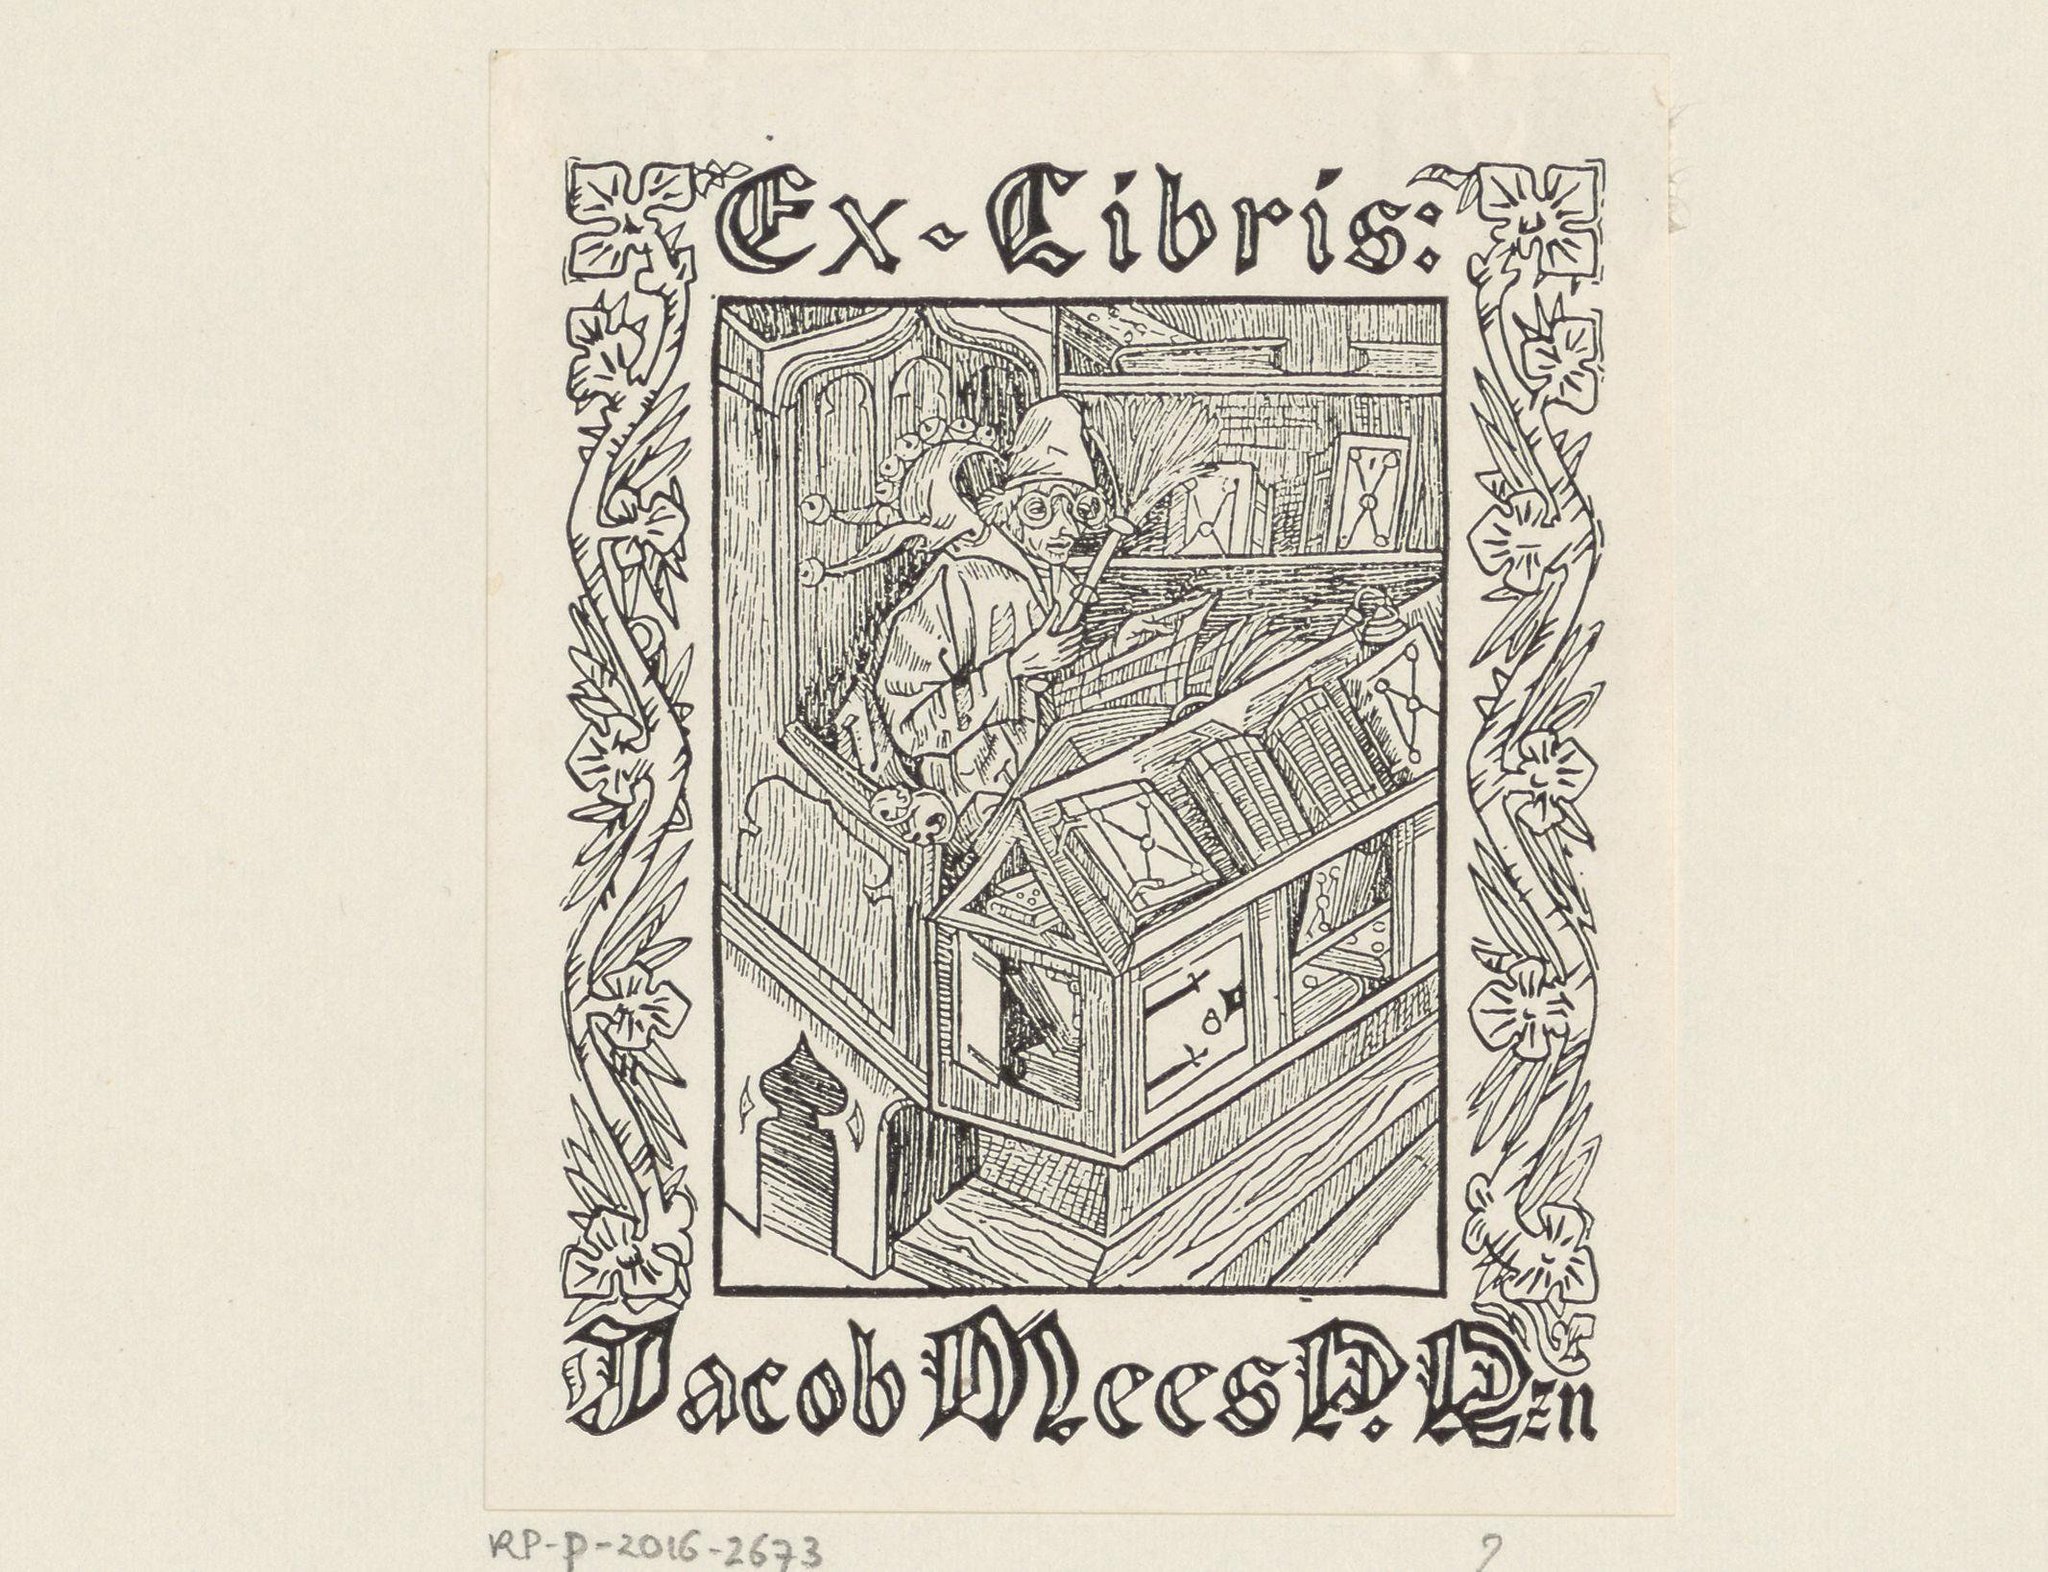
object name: bookplate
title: Ex libris van Jacob Mees P. Rzn.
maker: Anonymous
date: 1895-1970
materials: paper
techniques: printing block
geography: netherlands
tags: study; 'studiolo'; library, book, fool's cap